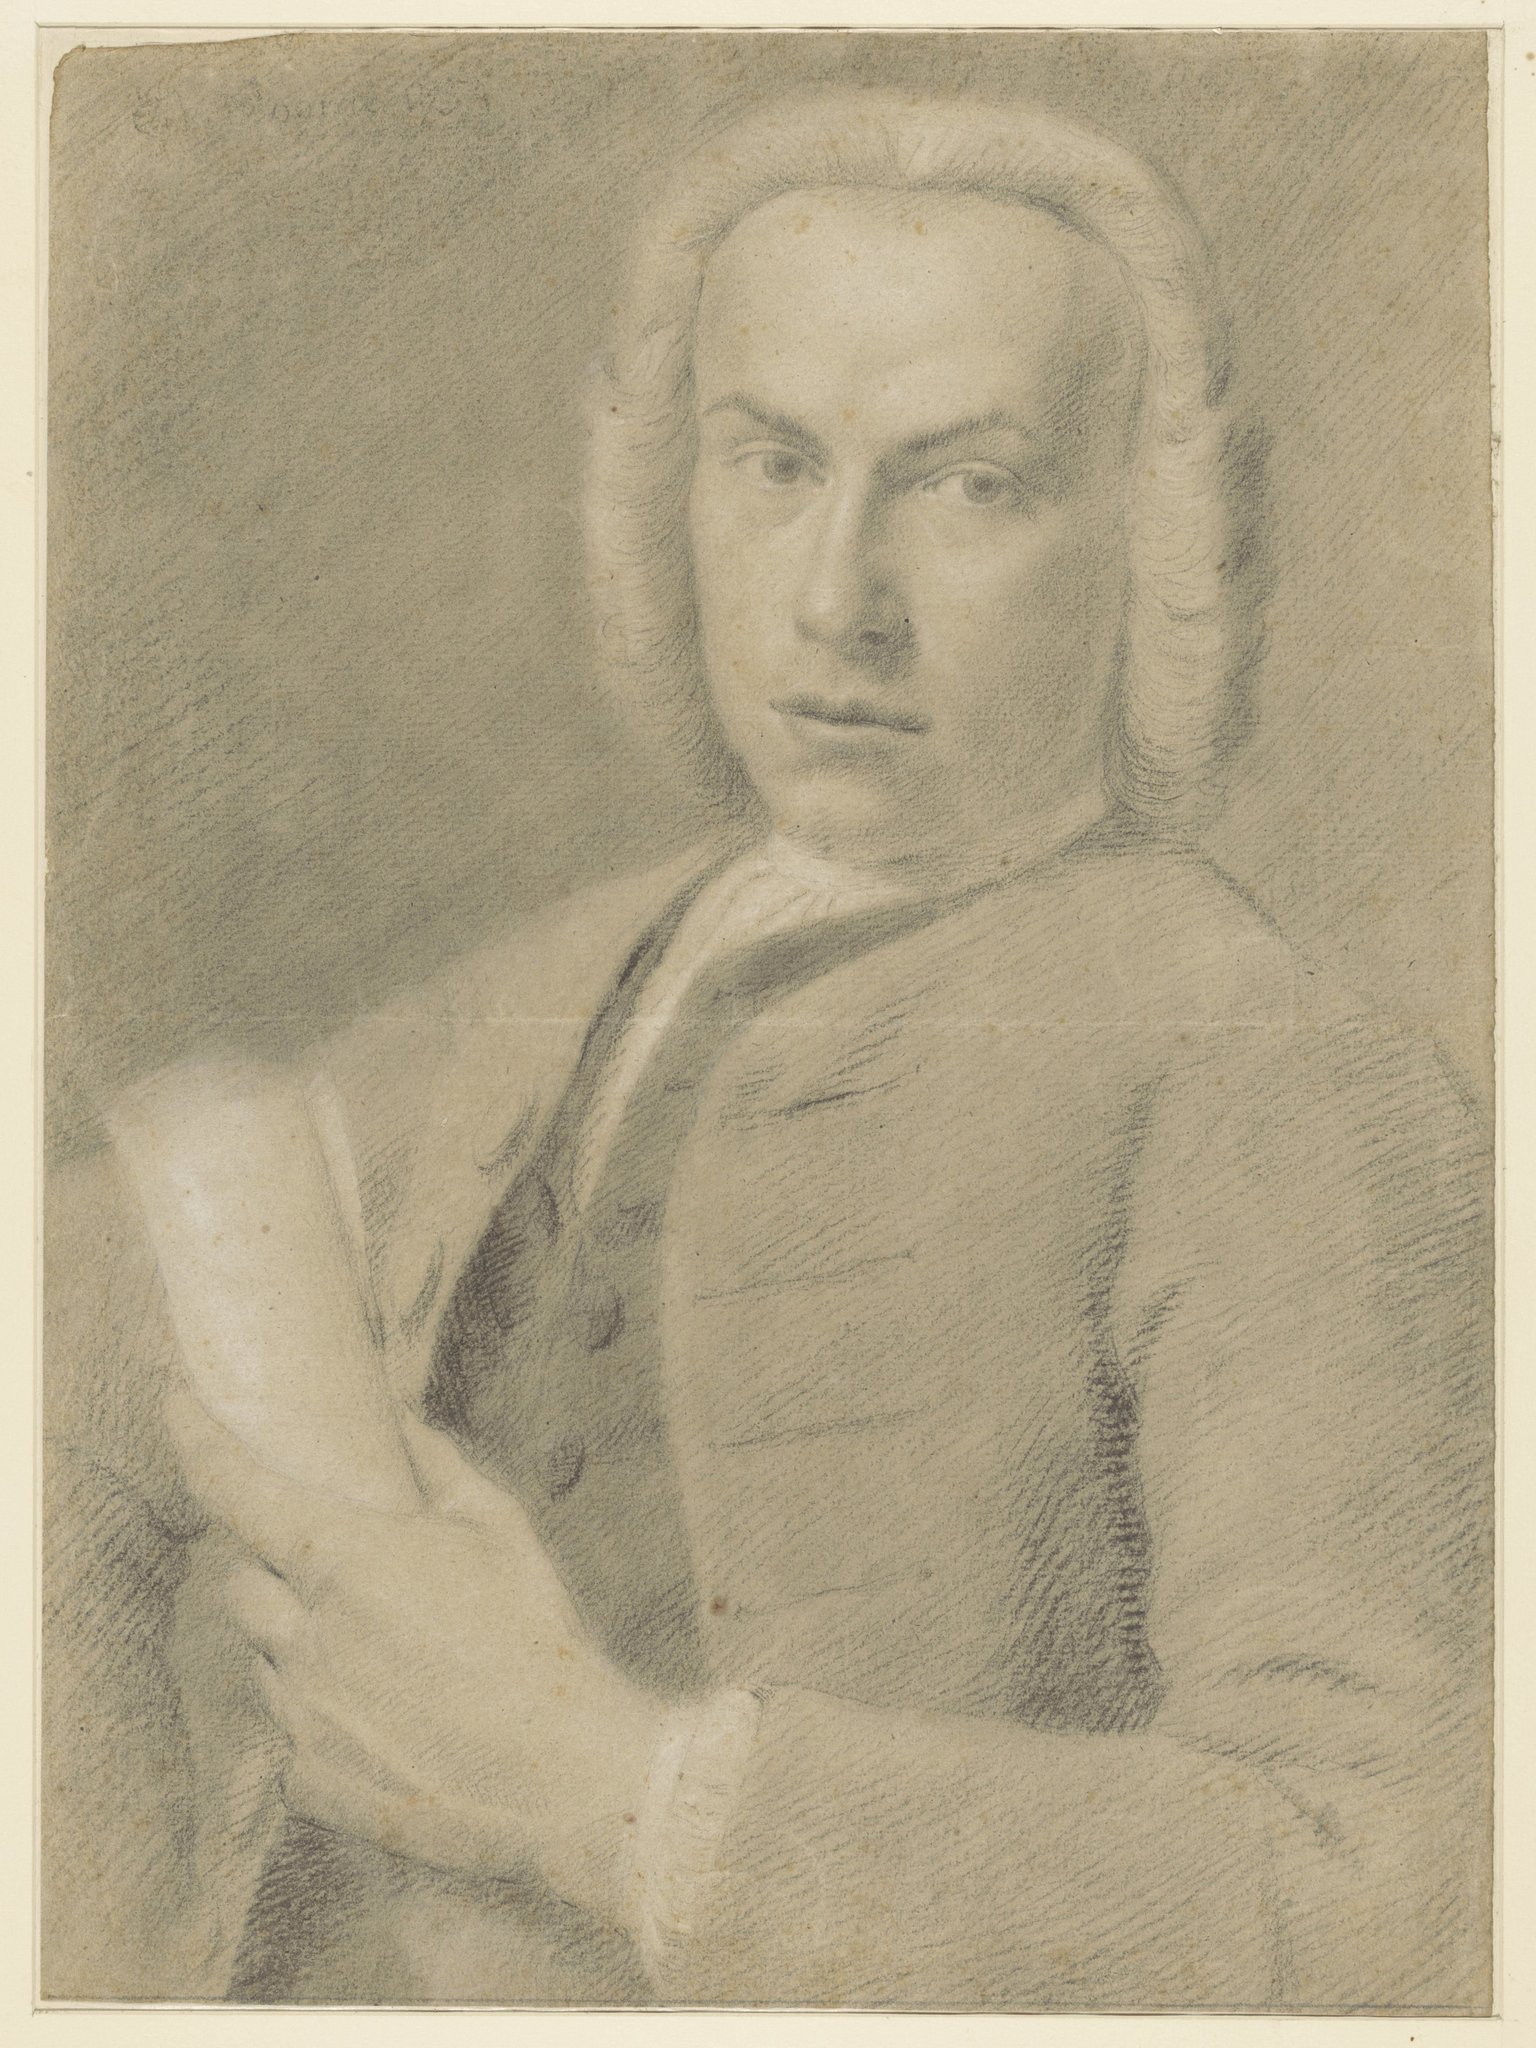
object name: drawing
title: Zelfportret van Cornelis van Noorde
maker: cornelis van noorde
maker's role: draughtsman, print maker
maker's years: 1731-1795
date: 1754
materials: chalk, paper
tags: haarlem, draughtsman, cornelis van noorde, historical persons, portrait, self-portrait of painter, portrait, self-portrait of artist, portrait, self-portrait of graphic artist, portrait, self-portrait of draughtsman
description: Zelfportret van de schilder, tekenaar en graveur Cornelis van Noorde.